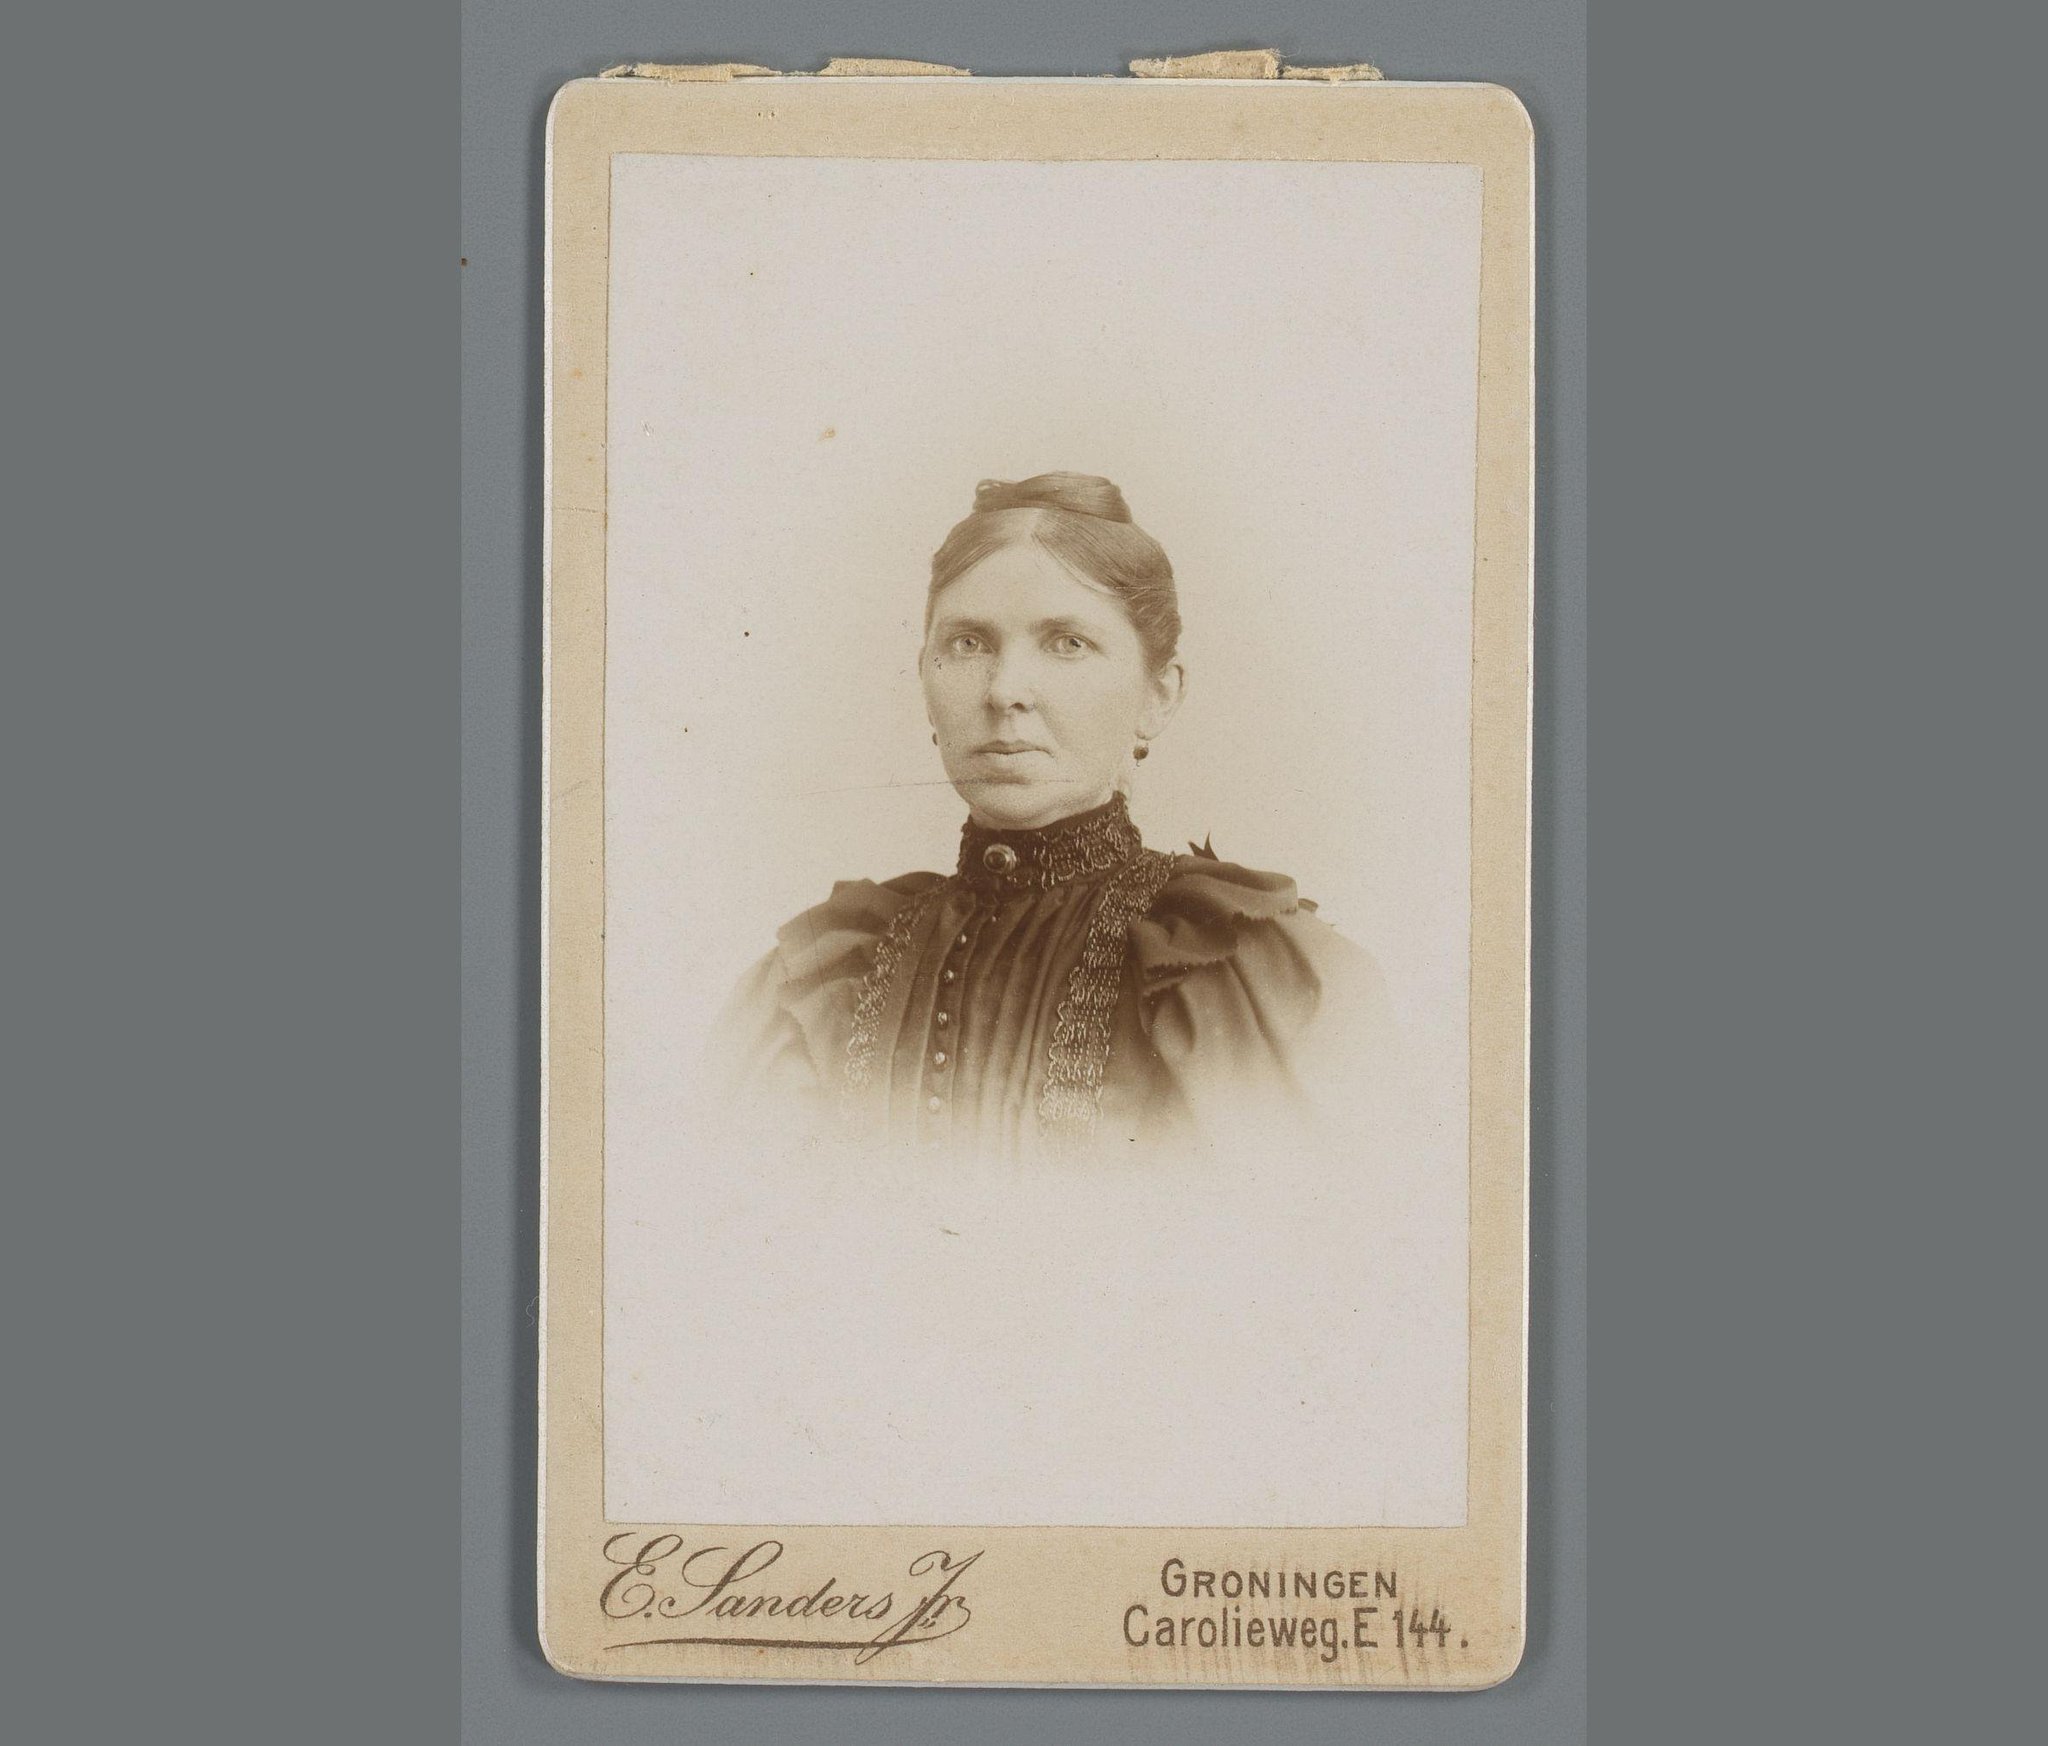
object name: photograph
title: Portret van Treintje Noordewier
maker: elkan sanders jr.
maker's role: fotograaf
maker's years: 1848-1932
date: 1894-1896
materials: paper, cardboard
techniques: gelatin silver print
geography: groningen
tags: historical persons - bb - woman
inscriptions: name: ‘Treintje Noordewier/ nicht v. Gr. Knol’, inscription: ‘ES/ Elkan Sanders Jr/ Photograaf/ Carolieweg. E 144,/ bij de Oosterstraat./ GRONINGEN./ Vergrootingen naar ieder portret.’